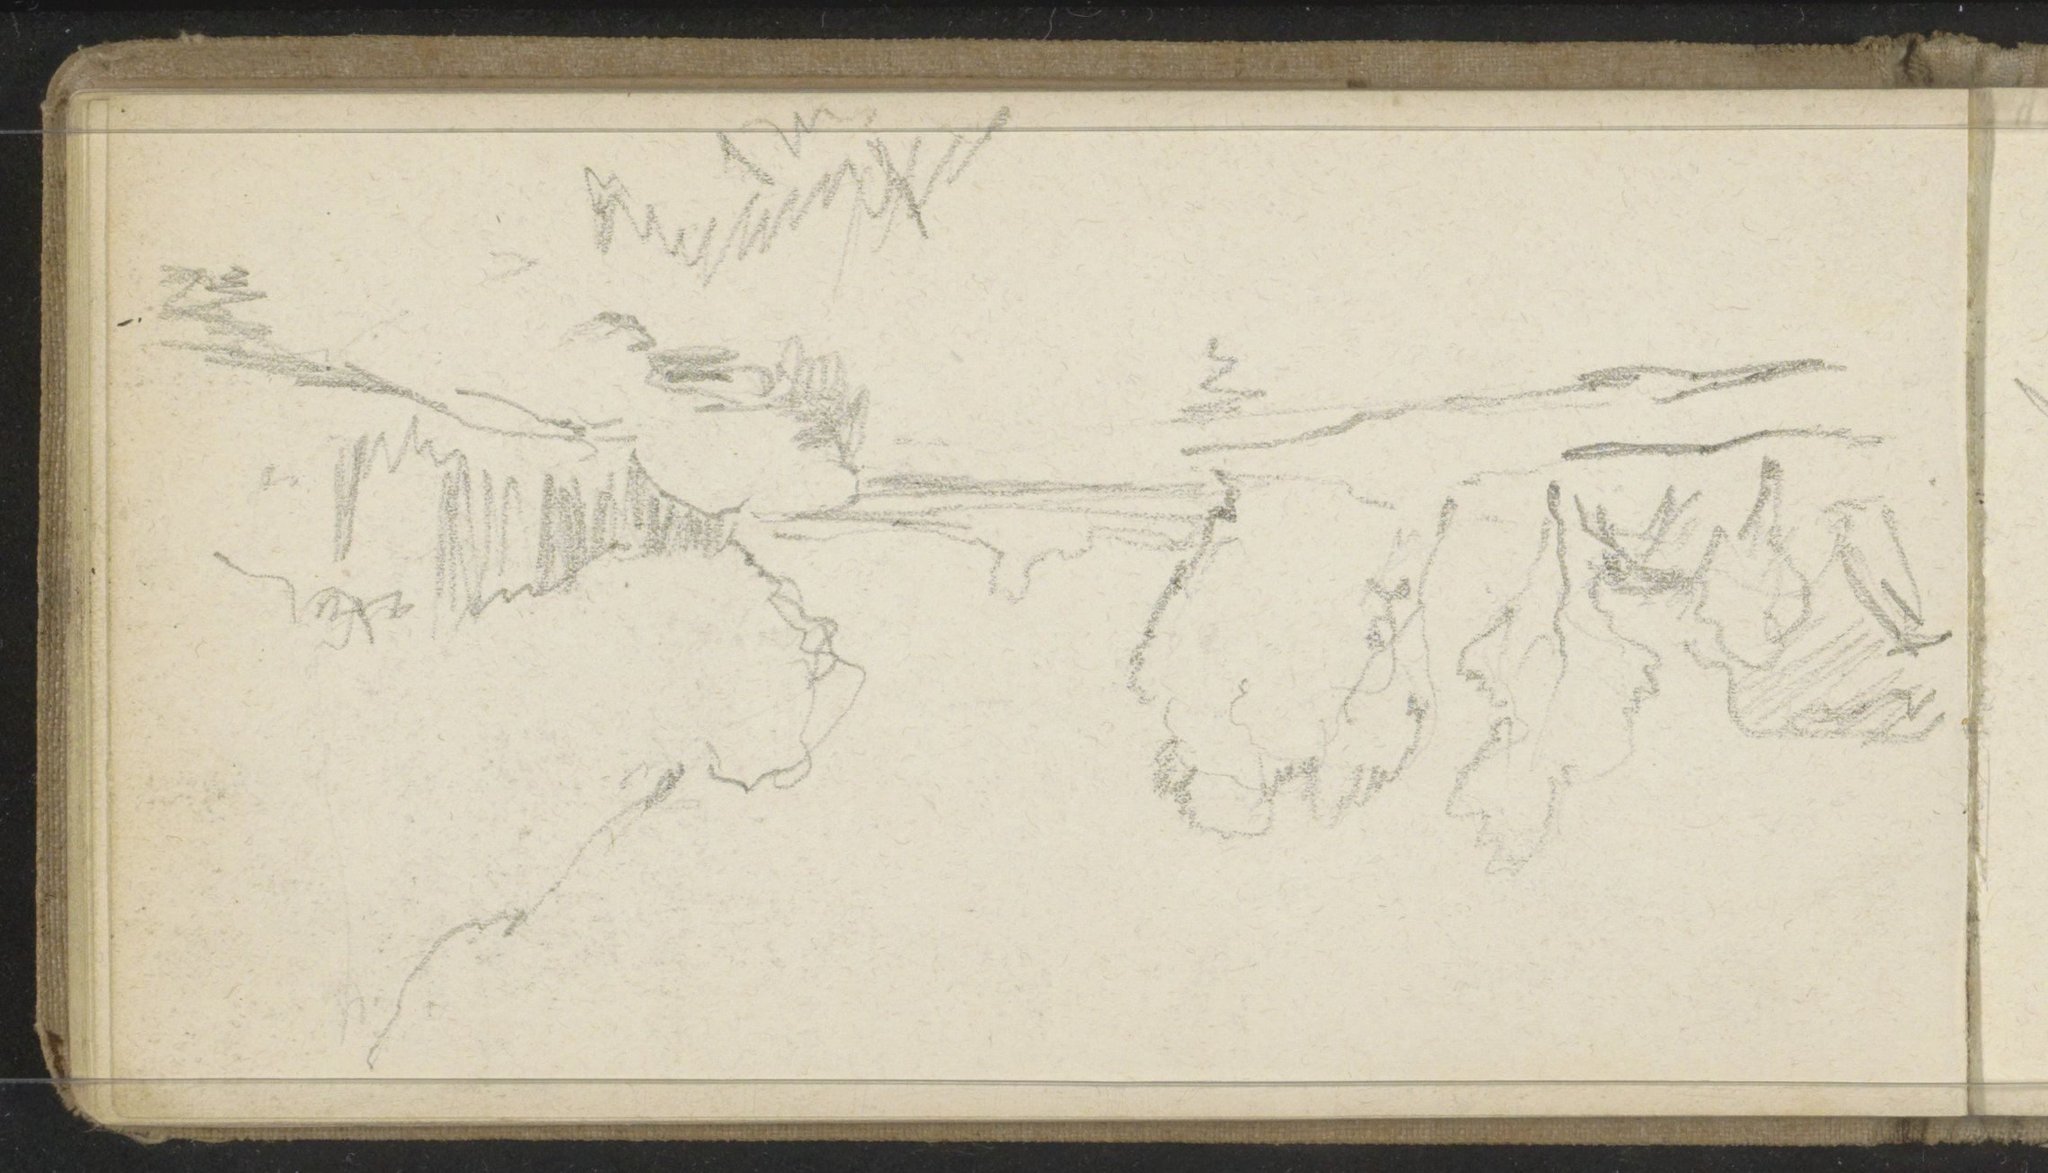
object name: sketchbook leaf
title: Landschap met water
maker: willem cornelis rip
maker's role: draughtsman, painter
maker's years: 1856-1922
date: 1895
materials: paper, pencil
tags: landscapes with waters, waterscapes, seascapes (in the temperate zone)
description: Blad 23 verso uit een schetsboek met 39 bladen.